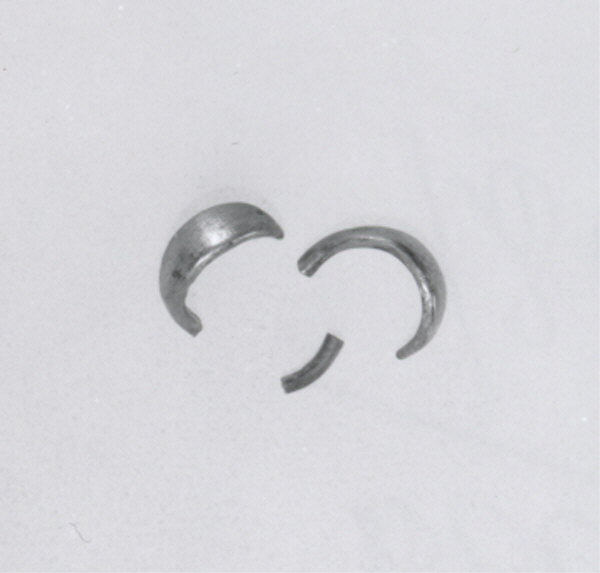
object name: ring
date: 2333-2001 BCE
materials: silver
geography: mesopotamia